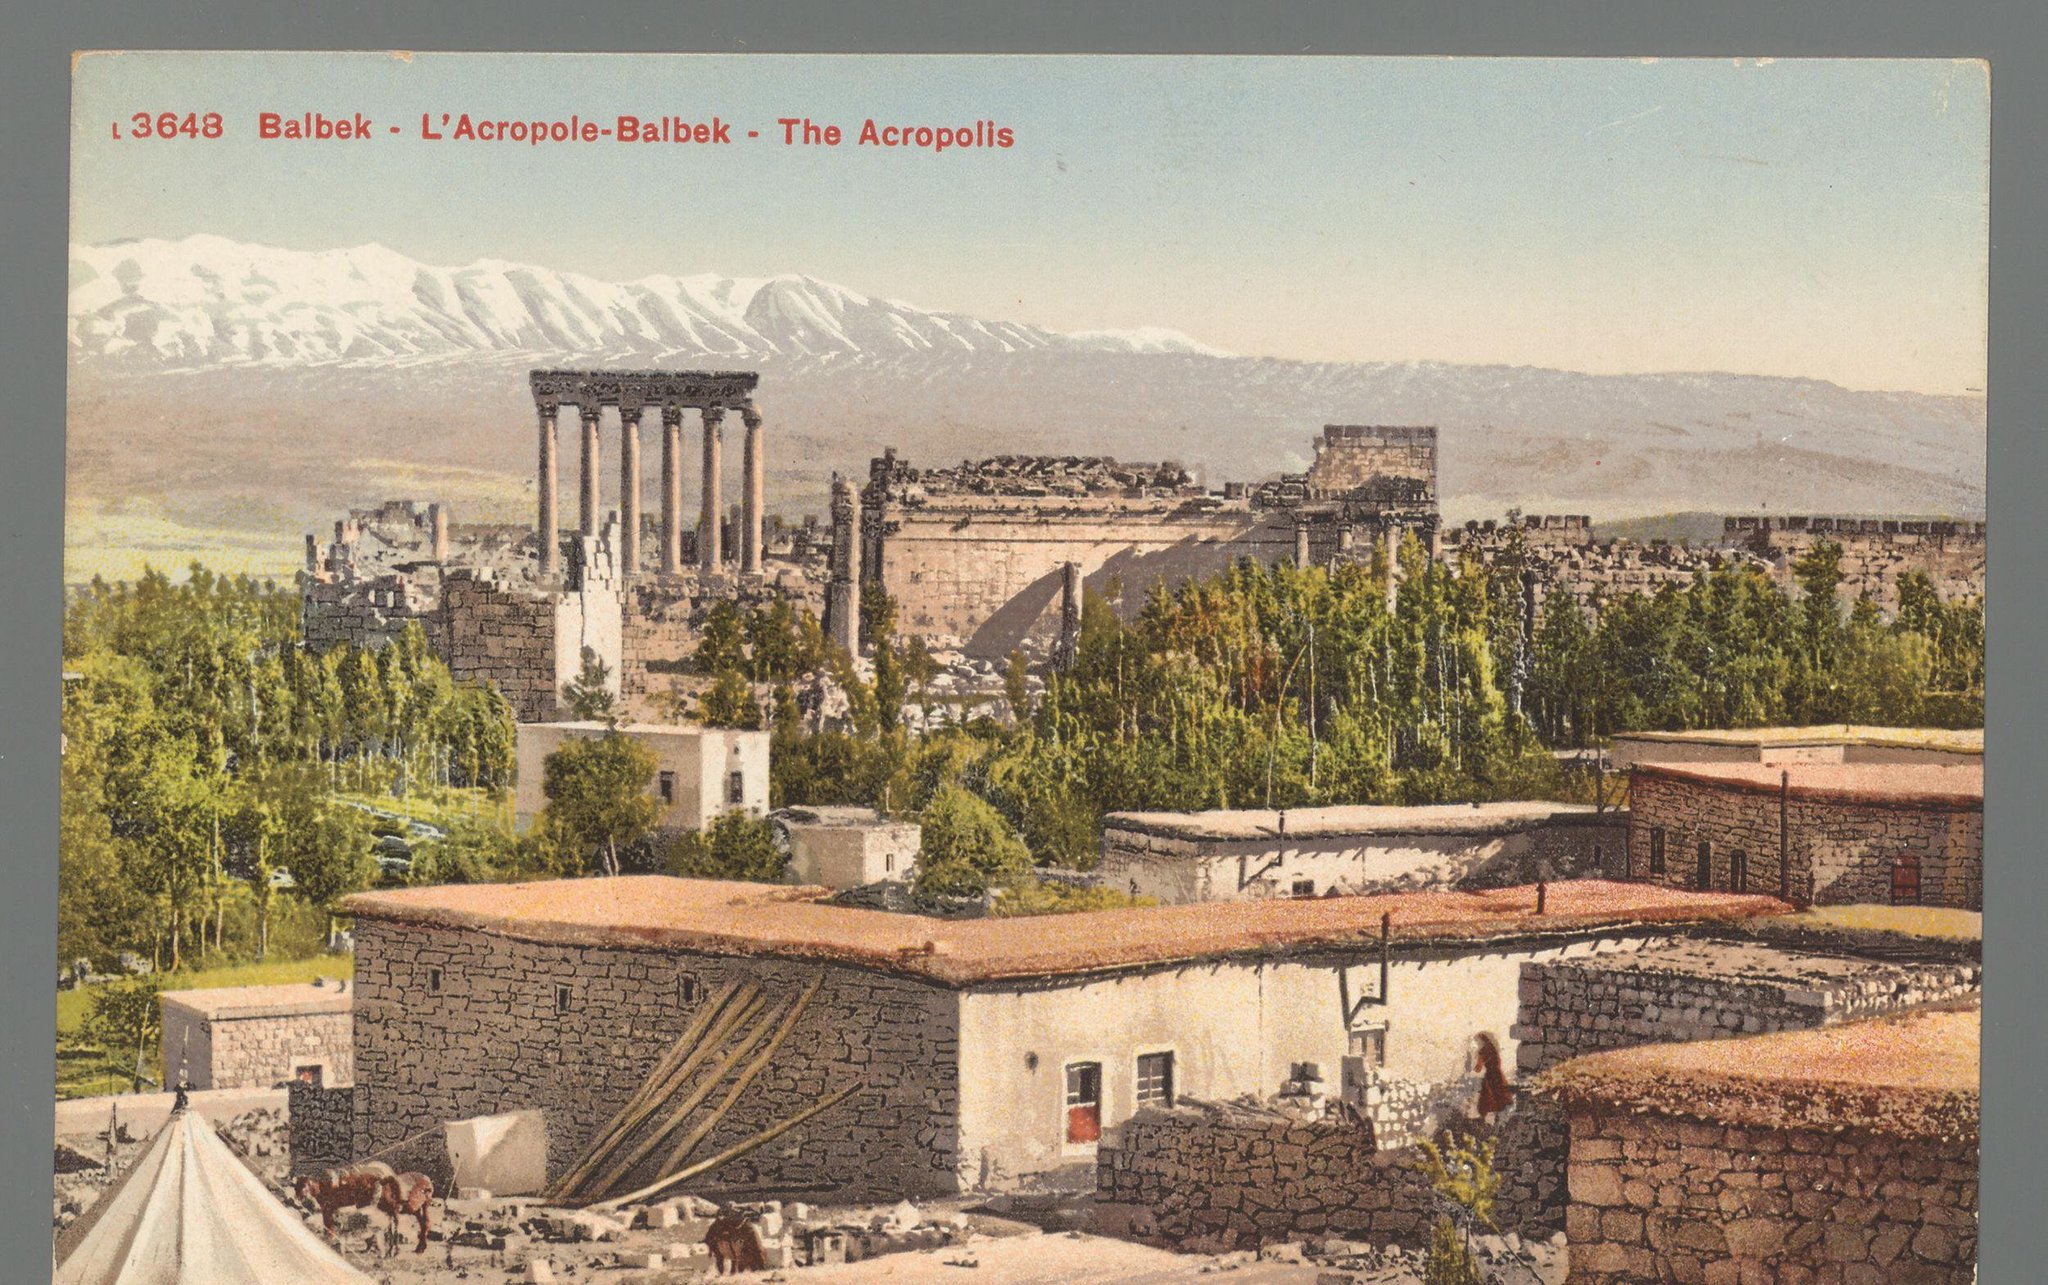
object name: ansichtkaart, prentbriefkaart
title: Balbek - L'Acropole-Balbek / The Acropolis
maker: Anonymous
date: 1906-1930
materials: cardboard, photographic process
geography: zurich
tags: landscape with ruins, temple, shrine ~ roman religion